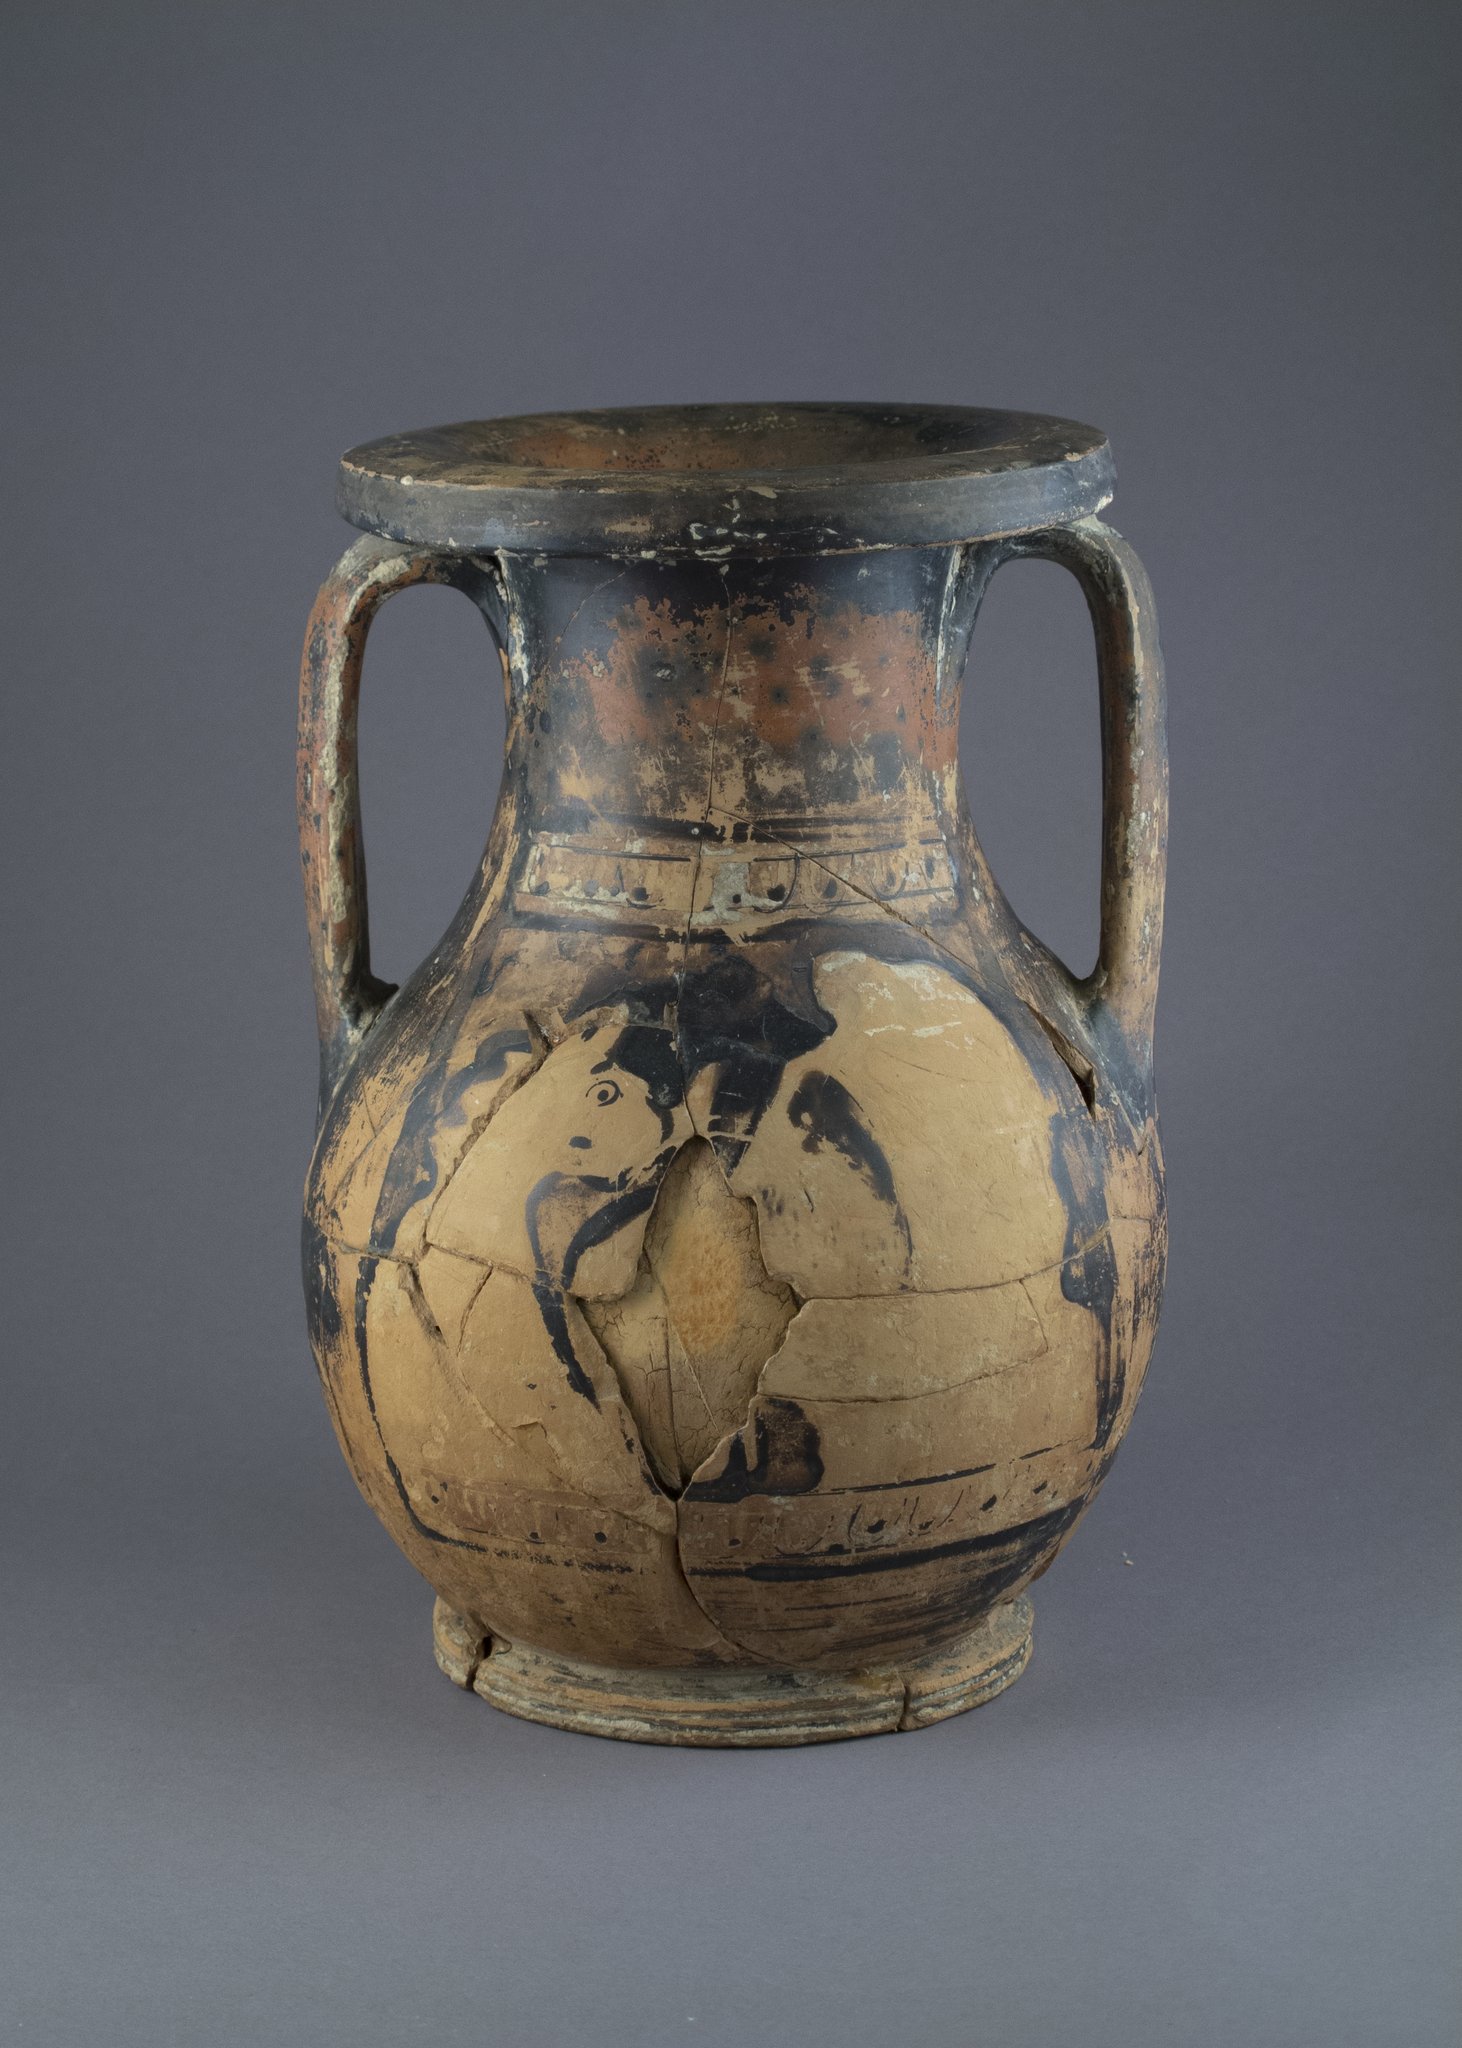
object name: pelike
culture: greek, attic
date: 400-301 BCE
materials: terracotta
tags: men,griffins